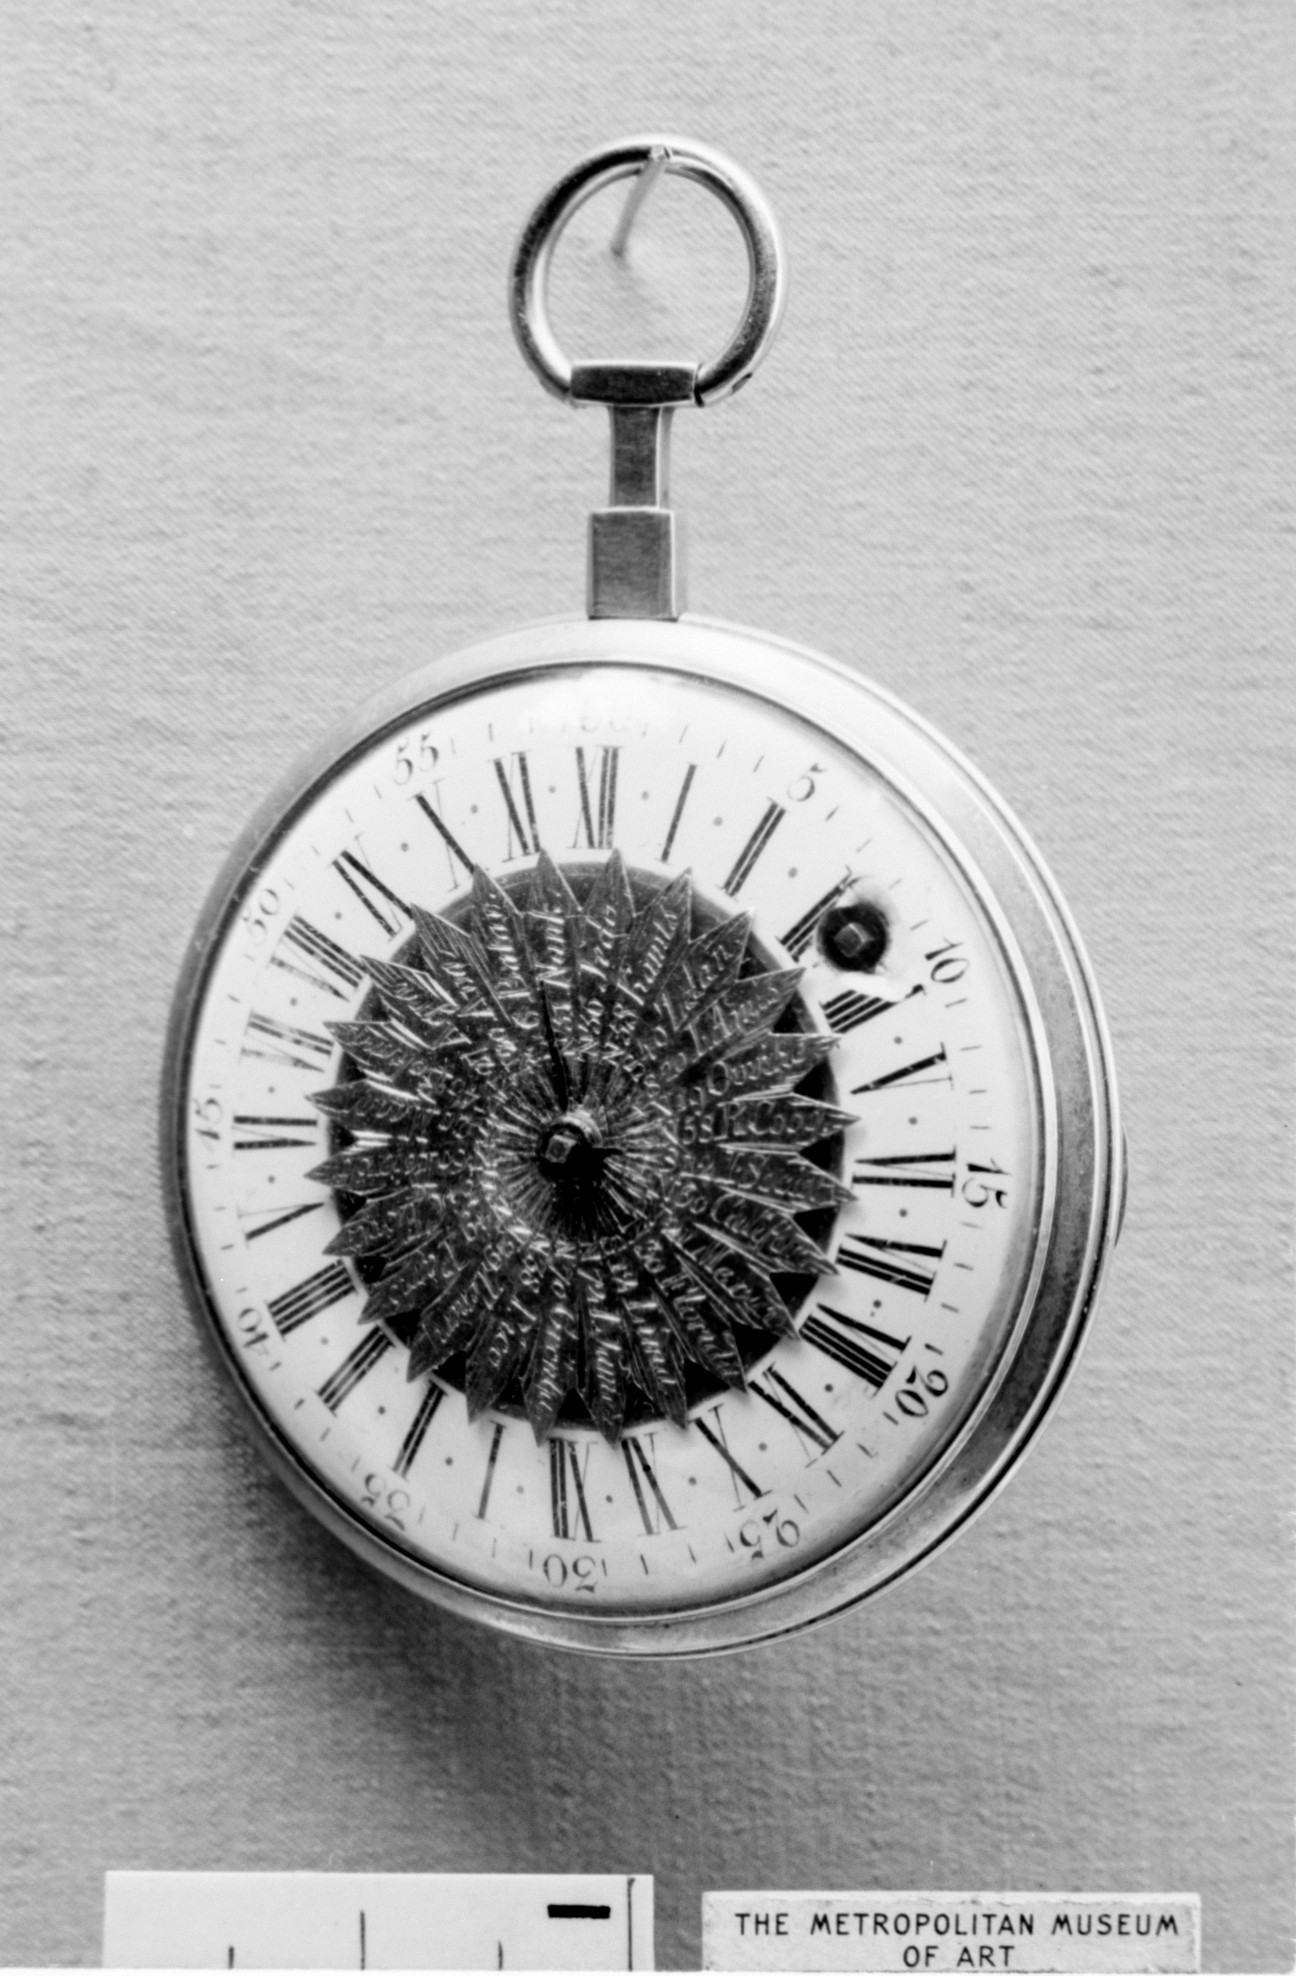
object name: pocket watch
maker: roches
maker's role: maker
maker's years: 1800-1900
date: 1801-1900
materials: enamel, gold